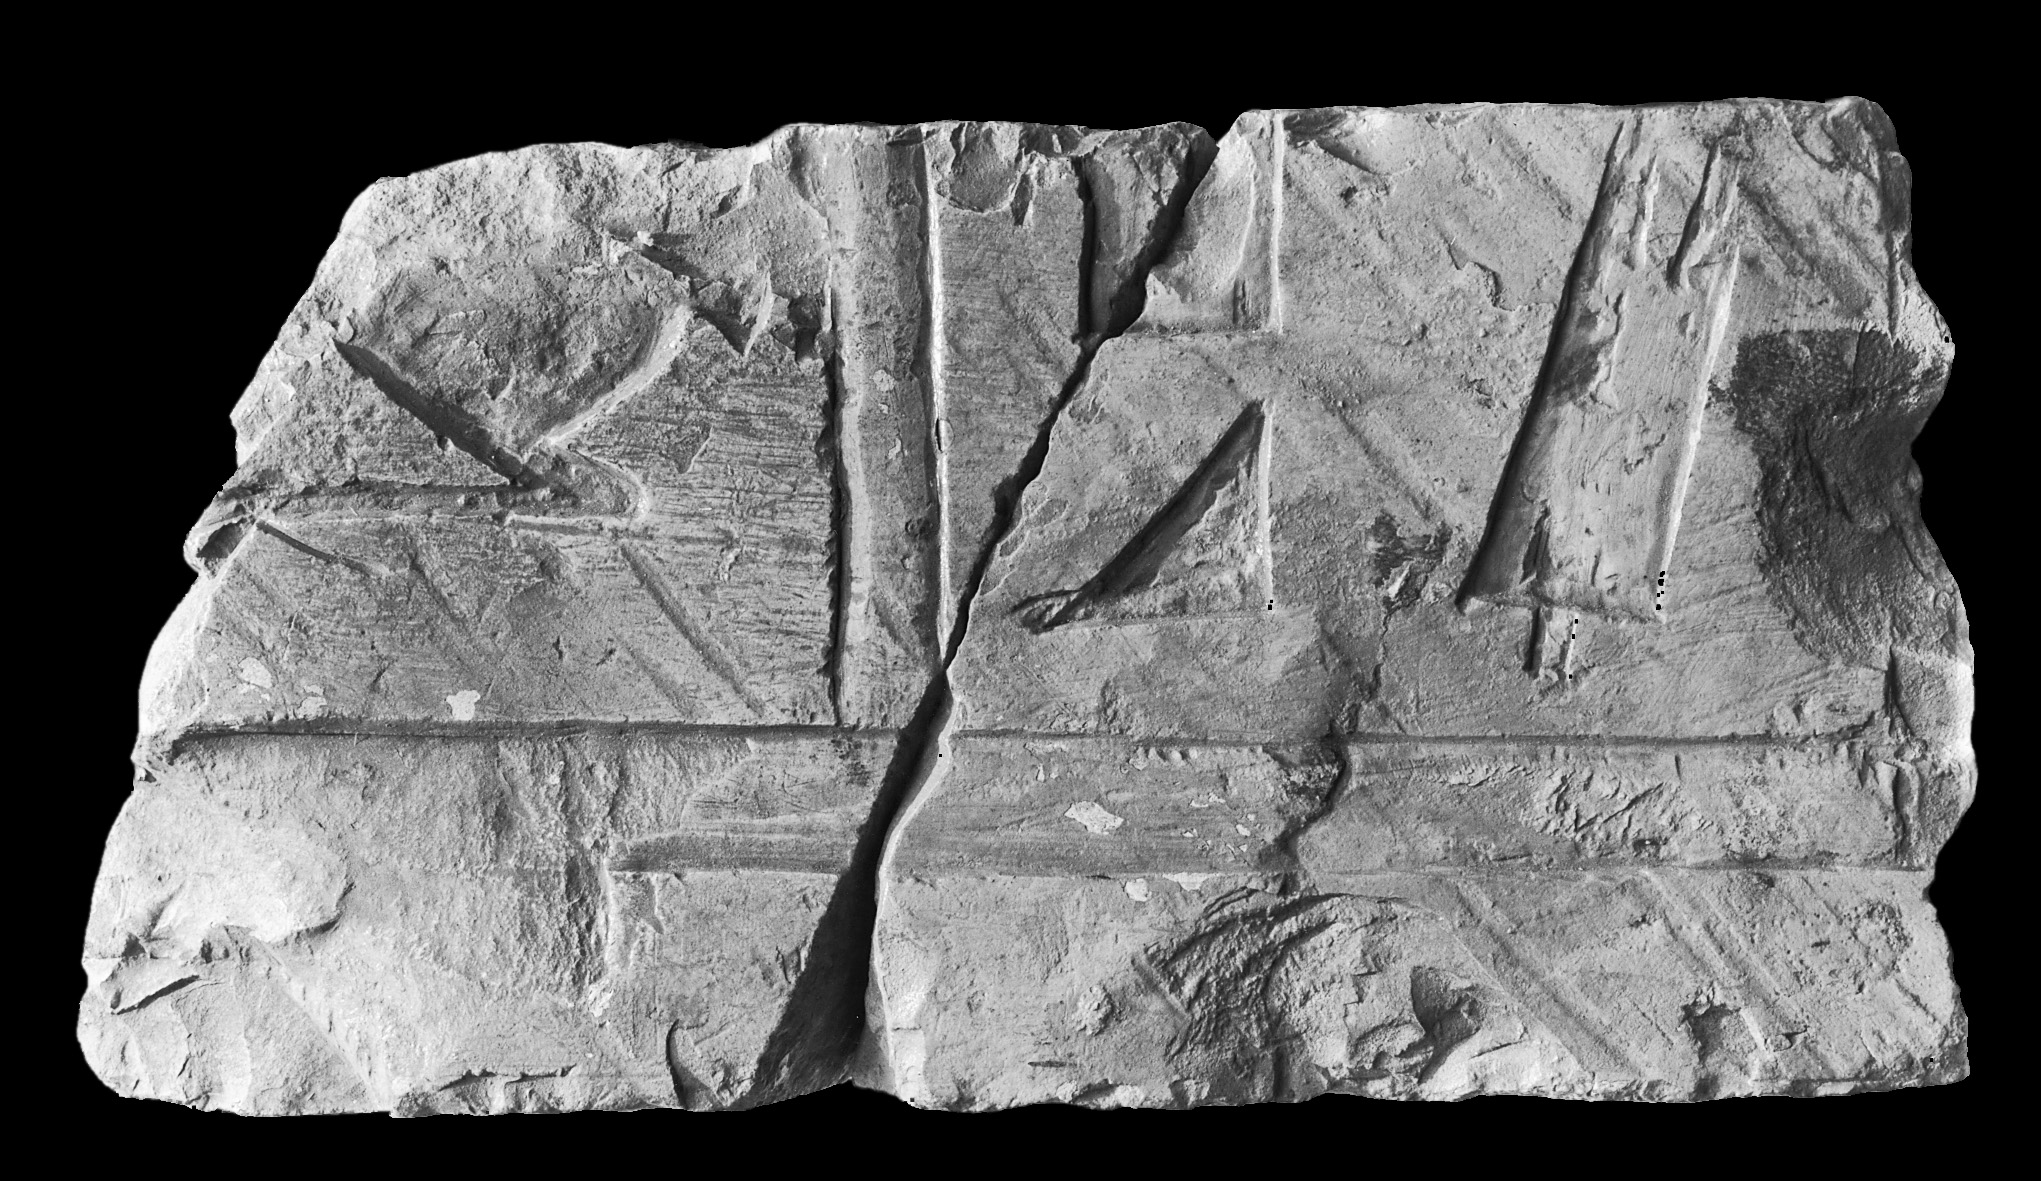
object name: relief, tomb of nespekashuty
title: Sunk relief fragment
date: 664-610 BCE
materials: limestone, varnish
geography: egypt